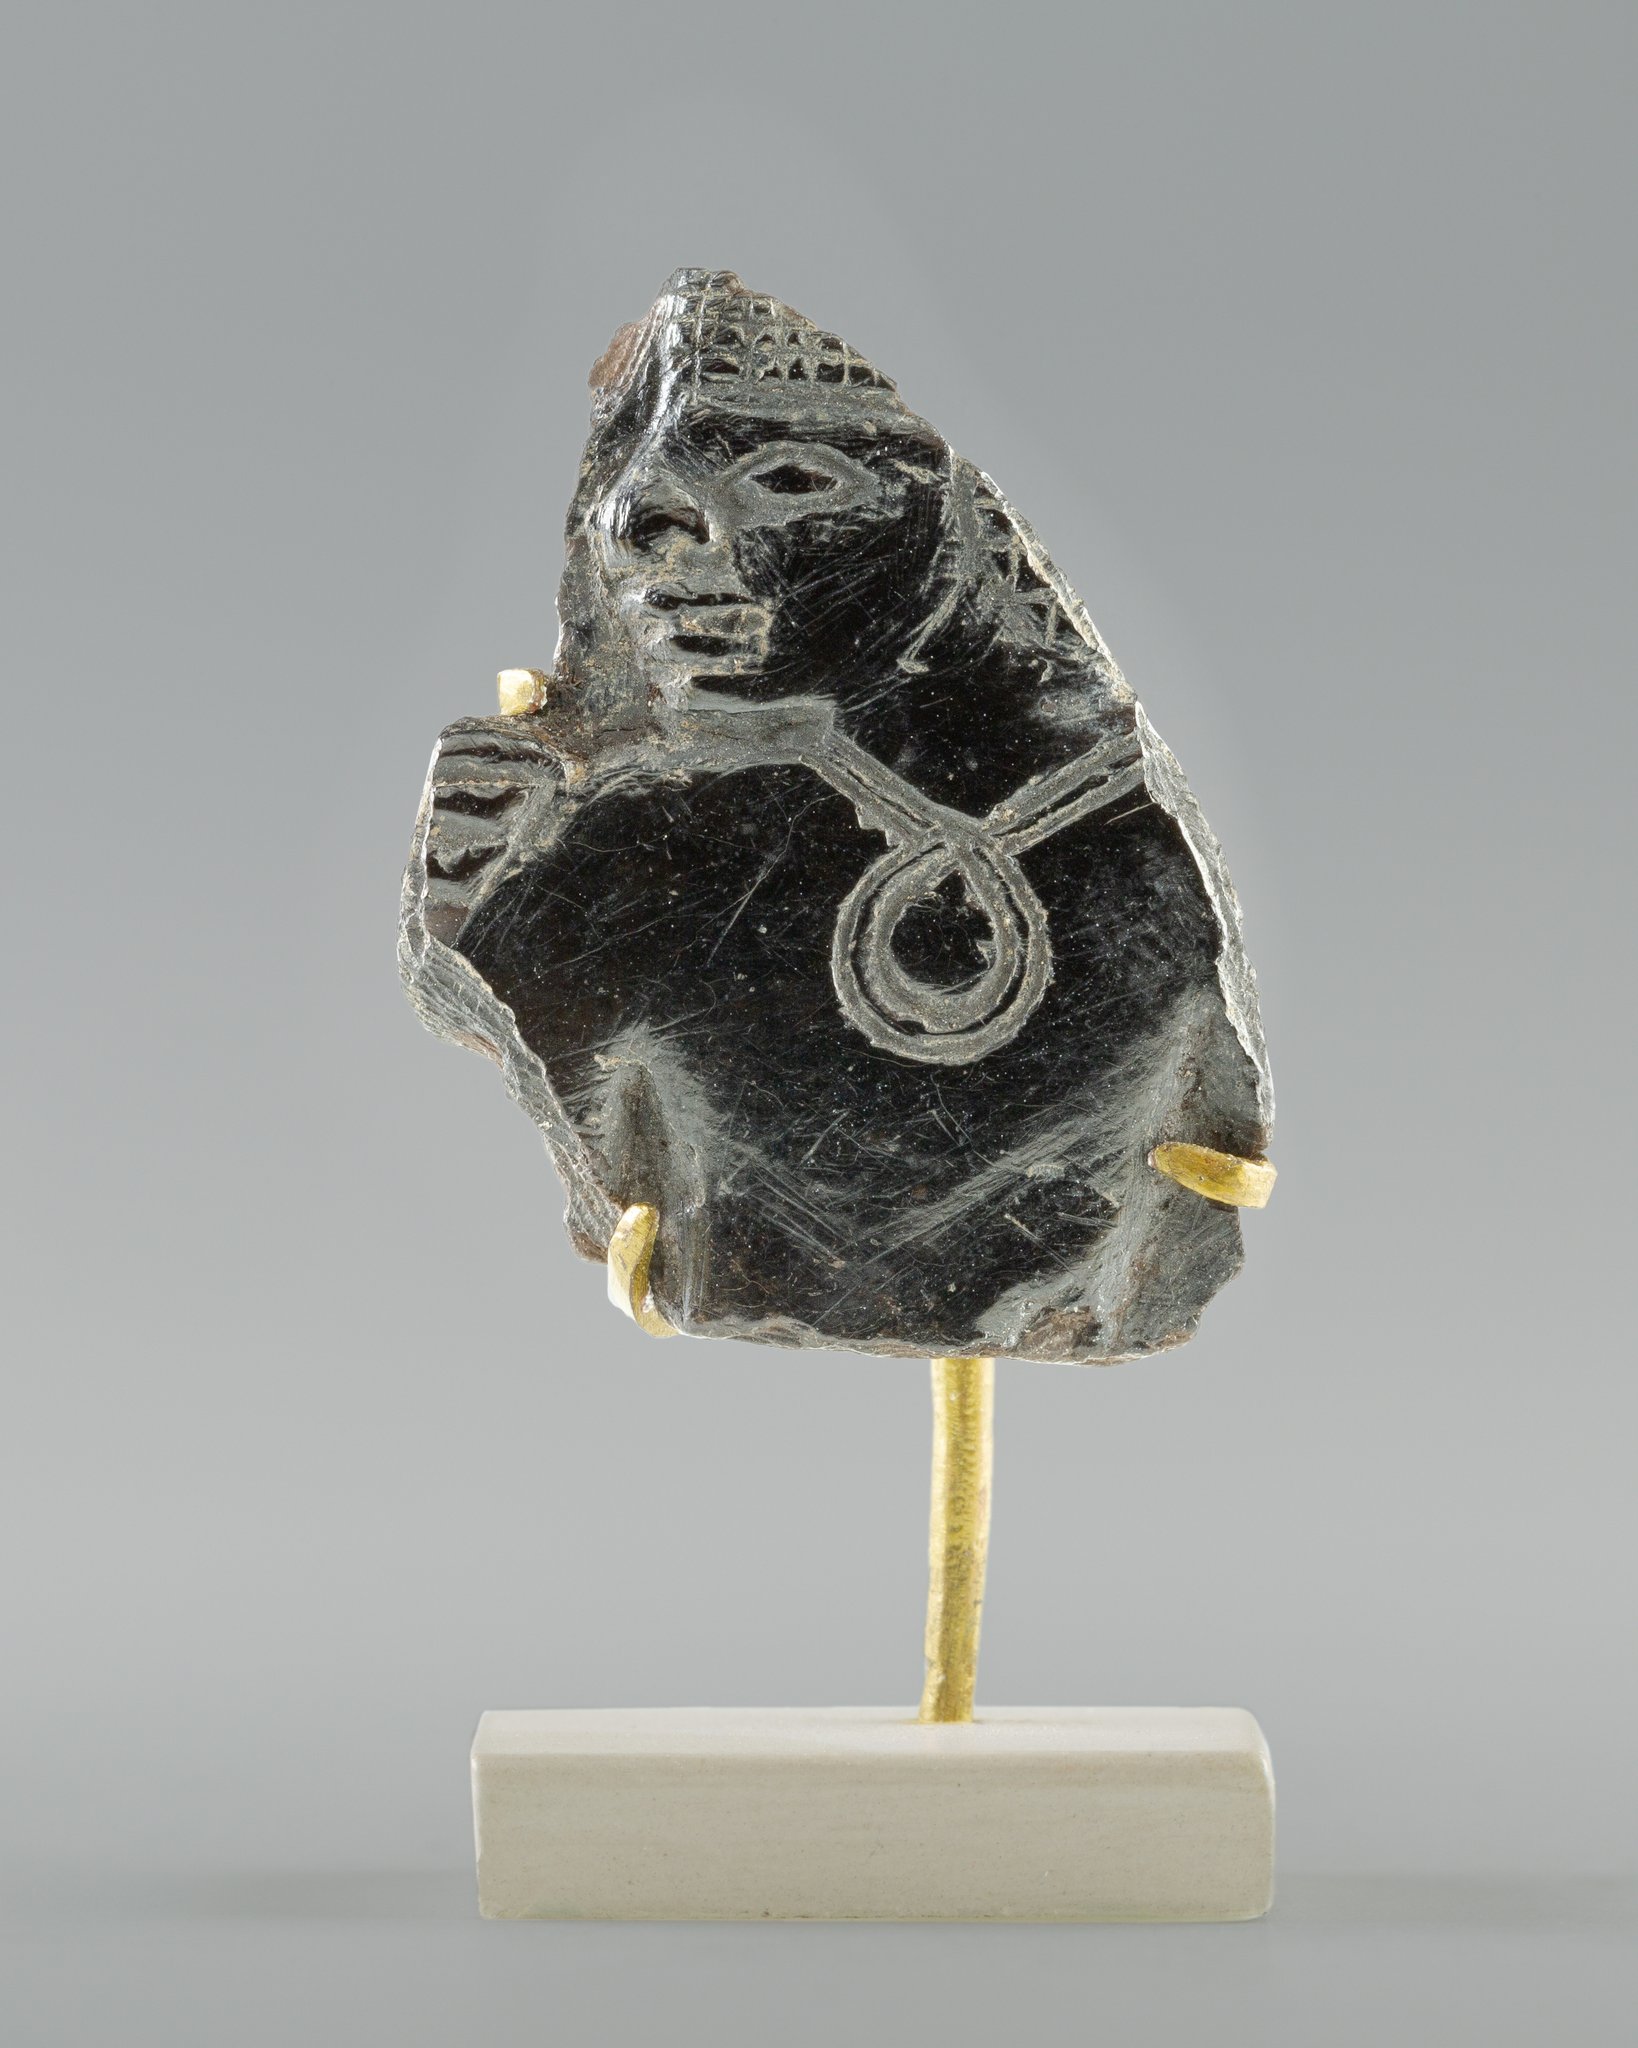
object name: relief, head of nubian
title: Relief fragment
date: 1981-1640 BCE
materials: limestone, marble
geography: egypt